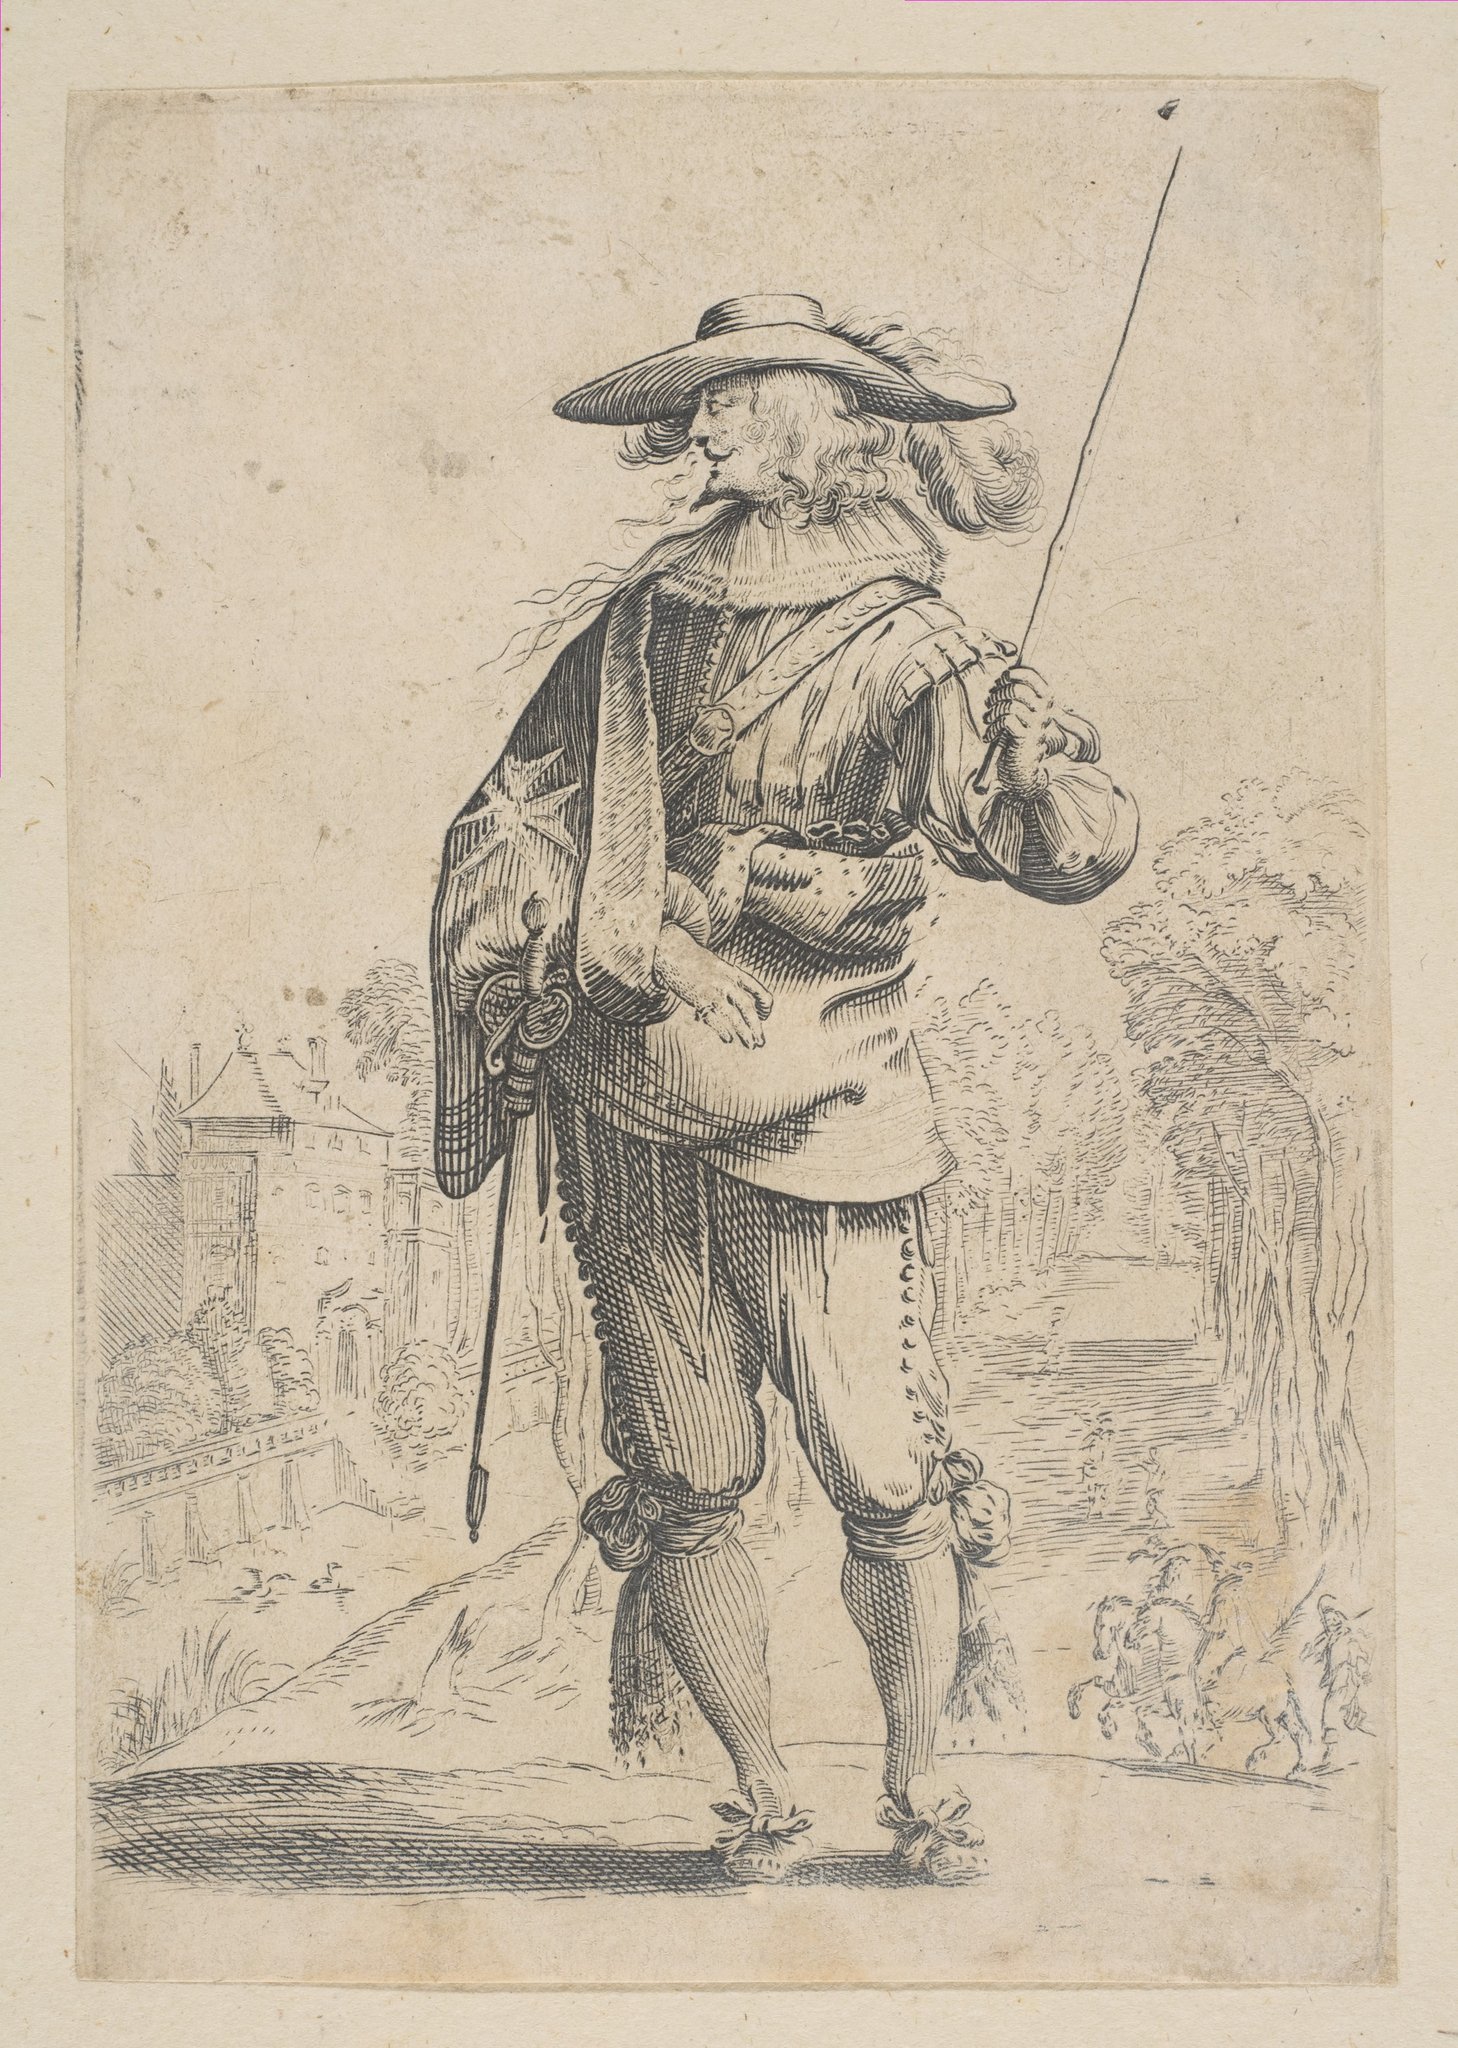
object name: print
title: A Man Holding a Crop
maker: anonymous, french, 17th century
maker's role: artist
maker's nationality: french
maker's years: 1600-1700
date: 1629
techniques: etching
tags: men,portraits